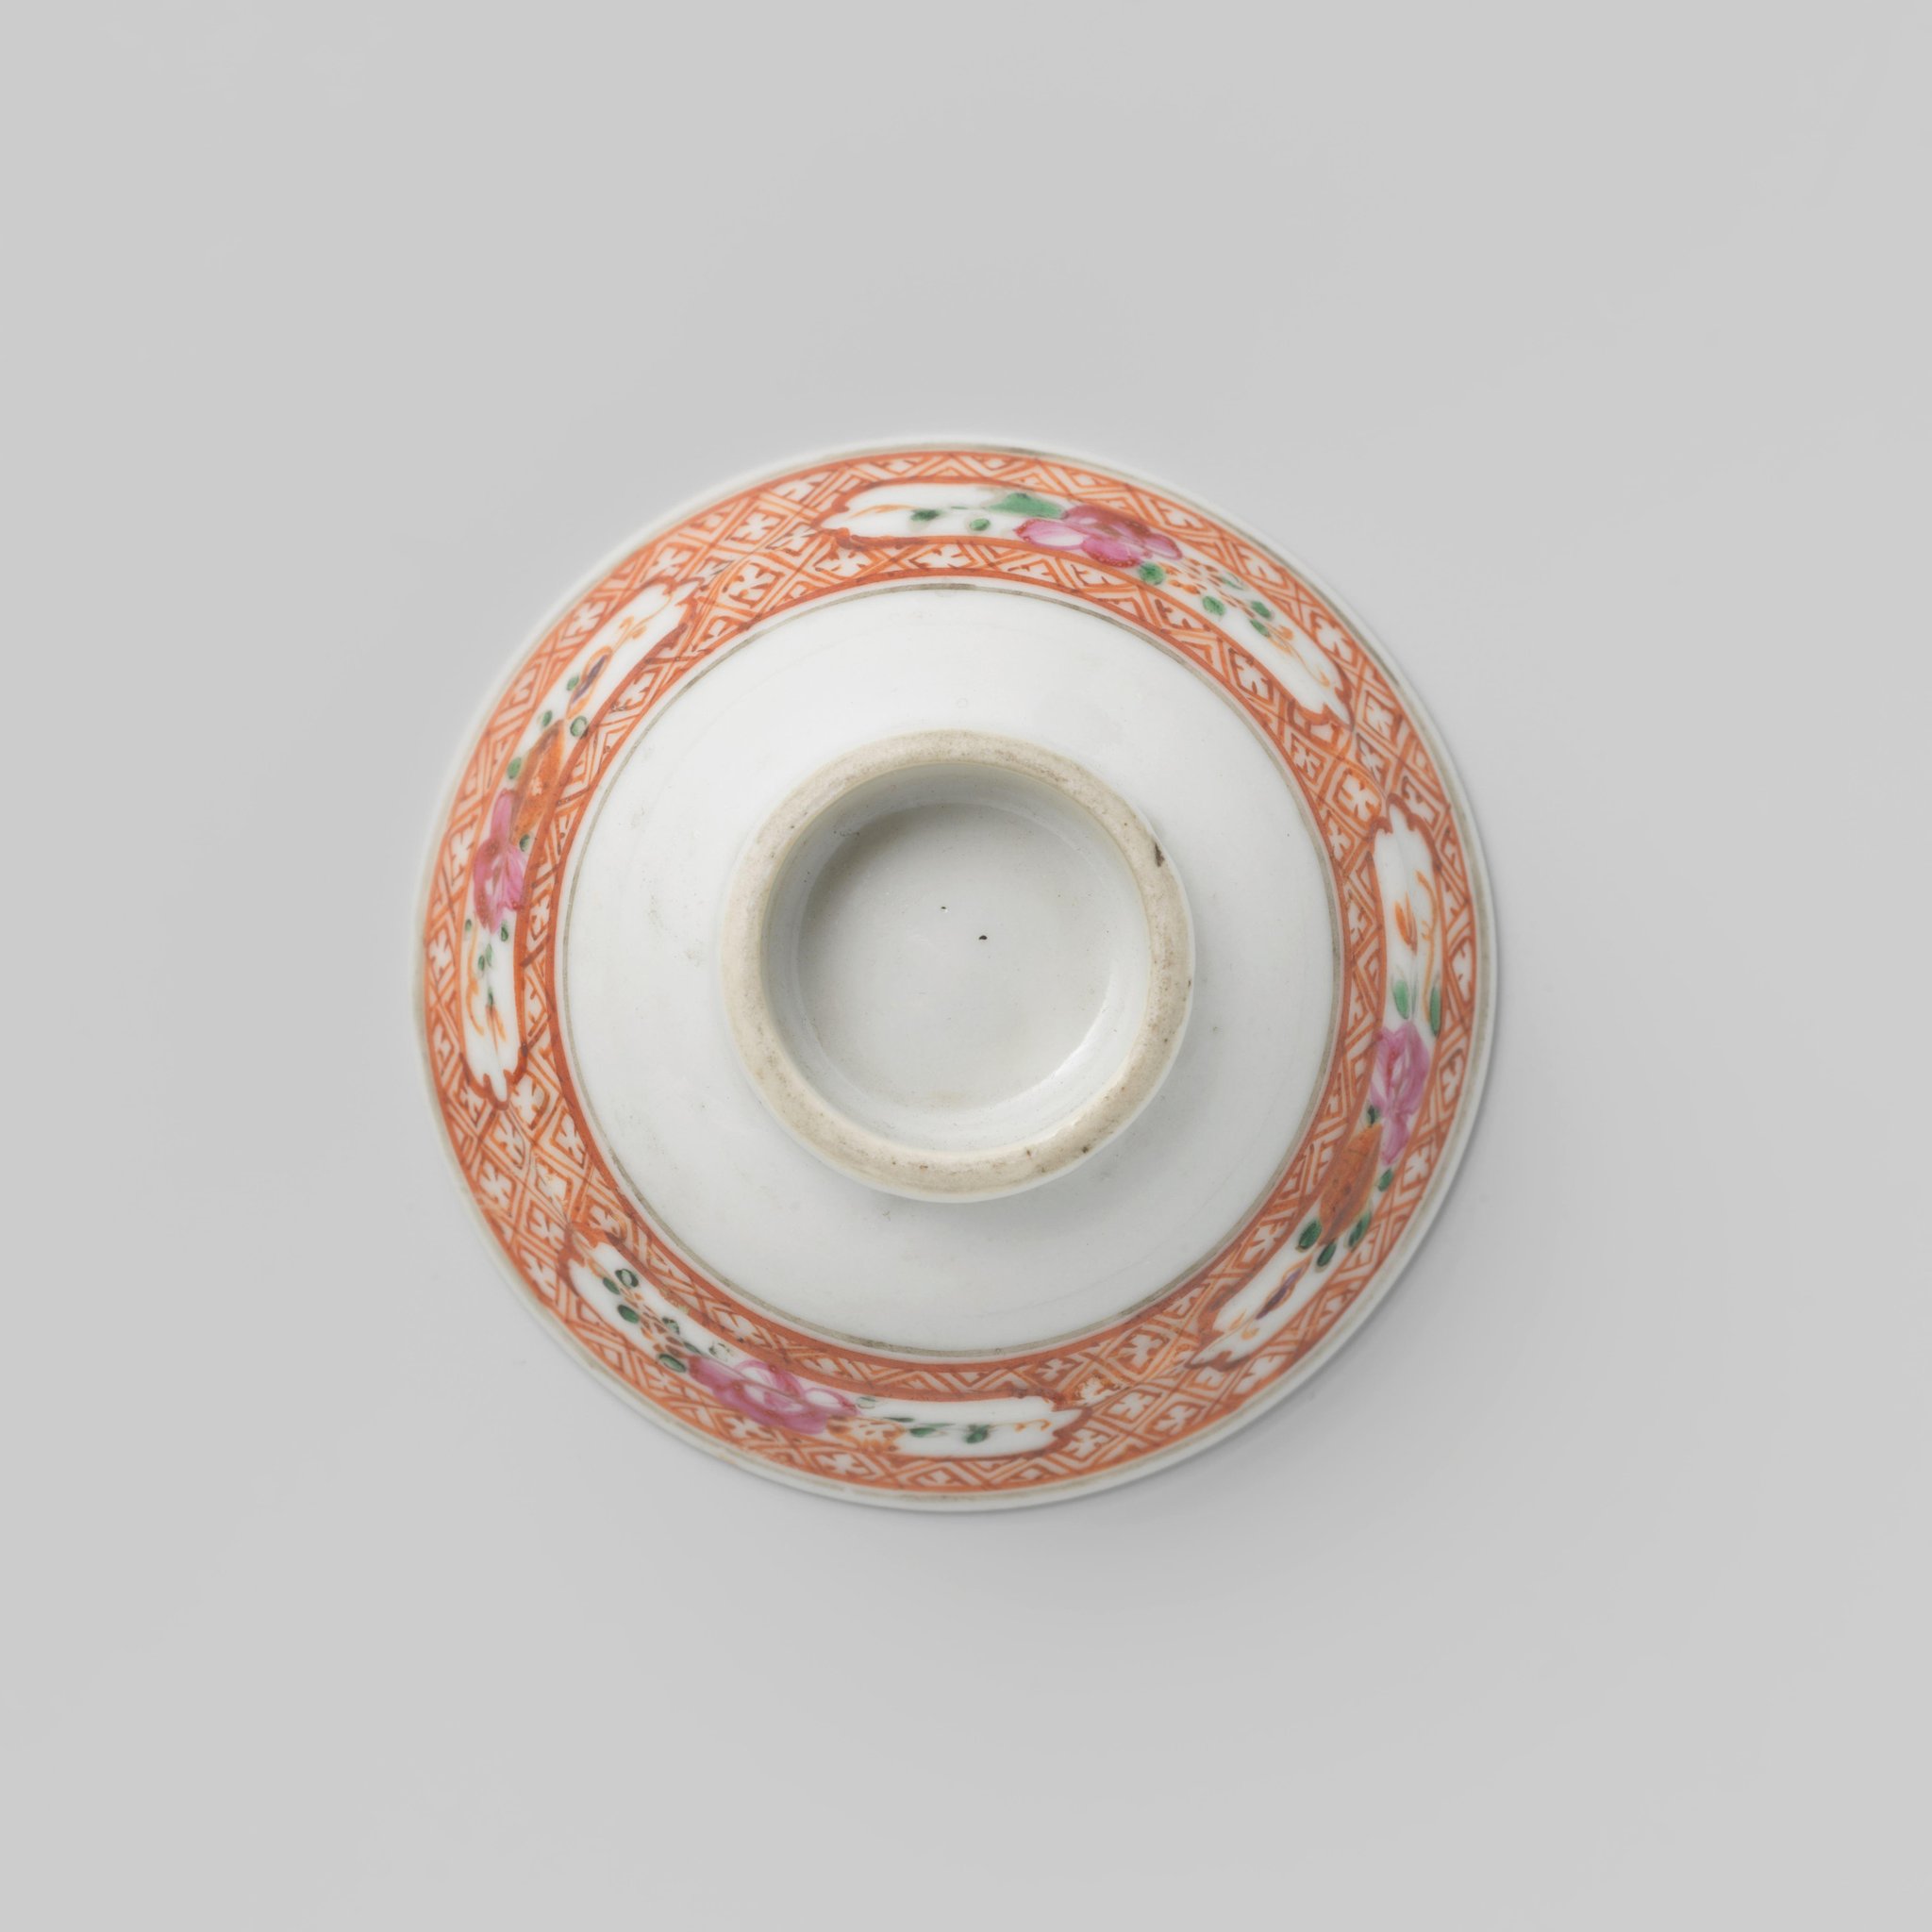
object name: kop en schotel, kop en schotel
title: Bell-shaped cup and saucer with bouquets and floral scrolls on a diaper-patters ground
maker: Anonymous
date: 1775-1799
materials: glaze, gold, paint, porcelain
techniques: firing, gilding, turning, vitrification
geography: china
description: Deksel van klokvormige dekselkop van porselein, beschilderd op het glazuur in rood, roze, groen, zwart en goud. Op de wand een boeket met verschillende bloemen, omgeven door vier kleinere boeketten; de rand met bloemranken in langwerpige cartouches uitgespaard in een achtergrond van servetwerk. Famille rose.